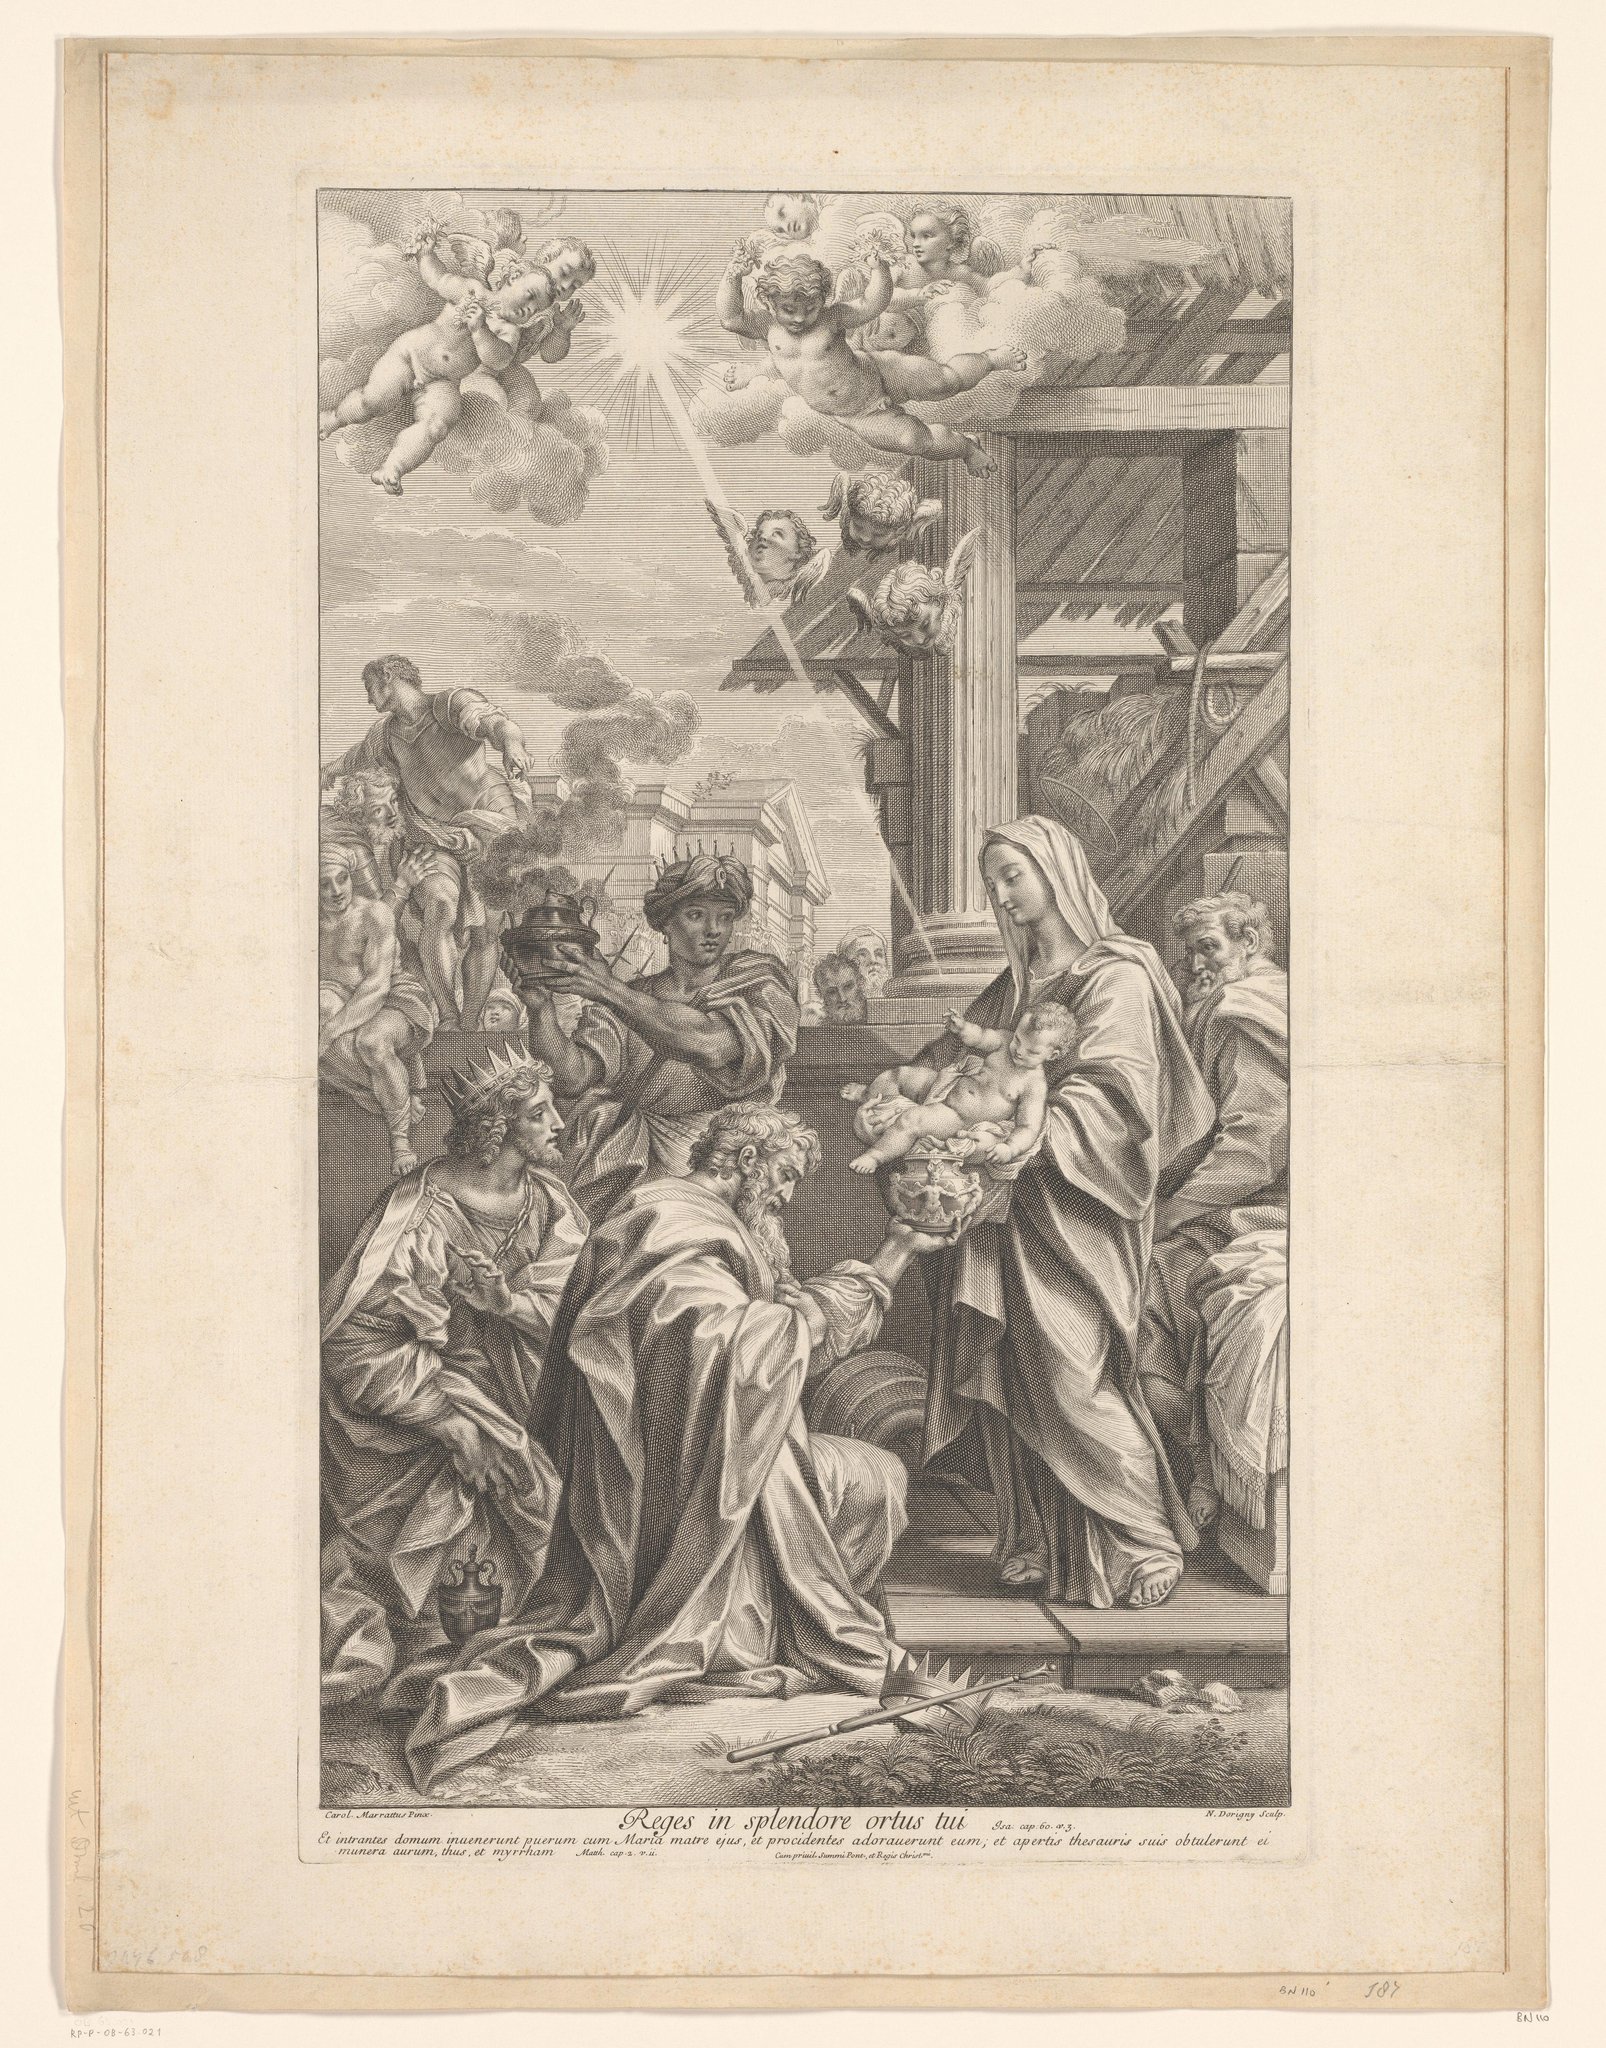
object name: print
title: Aanbidding door de koningen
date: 1673-1700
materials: paper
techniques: engraving, etching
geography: rome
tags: adoration of the kings: the wise men present their gifts to the christ-child (gold, frankincense and myrrh) (+ donor(s), supplicant(s), whether or not with patron saint(s))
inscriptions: collector's mark: Lugt 2228